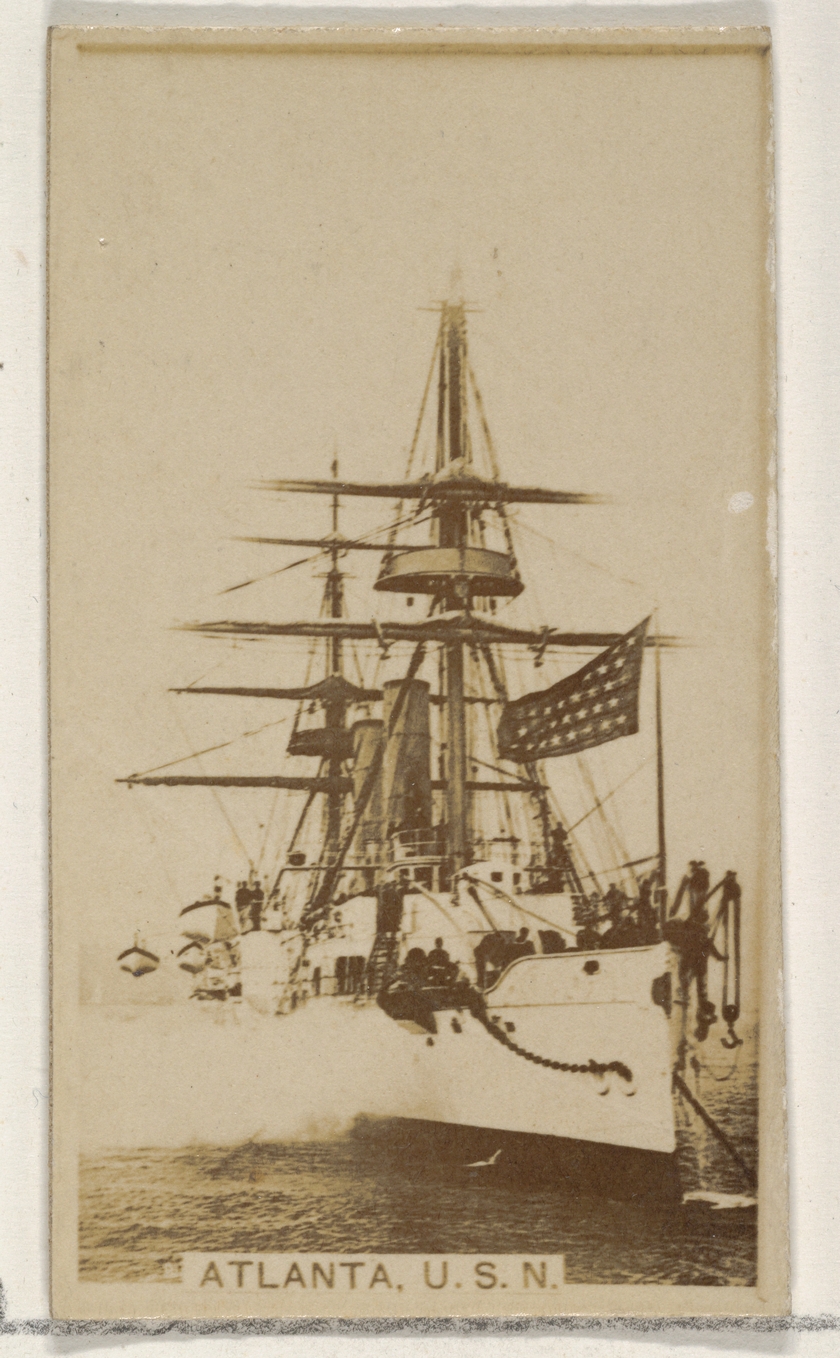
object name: photograph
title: Atlanta, U.S.N., from the Famous Ships series (N50) for Virginia Brights Cigarettes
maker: allen & ginter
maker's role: publisher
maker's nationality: american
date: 1895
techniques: albumen silver print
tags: ships